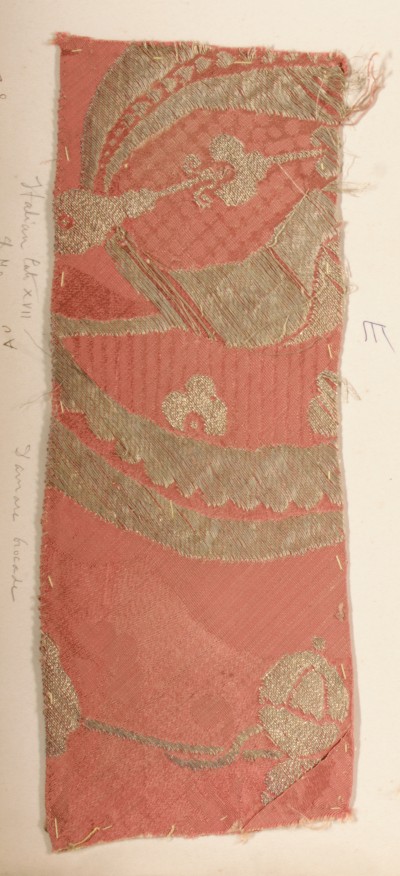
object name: fragment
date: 1701-1733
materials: metal thread, silk